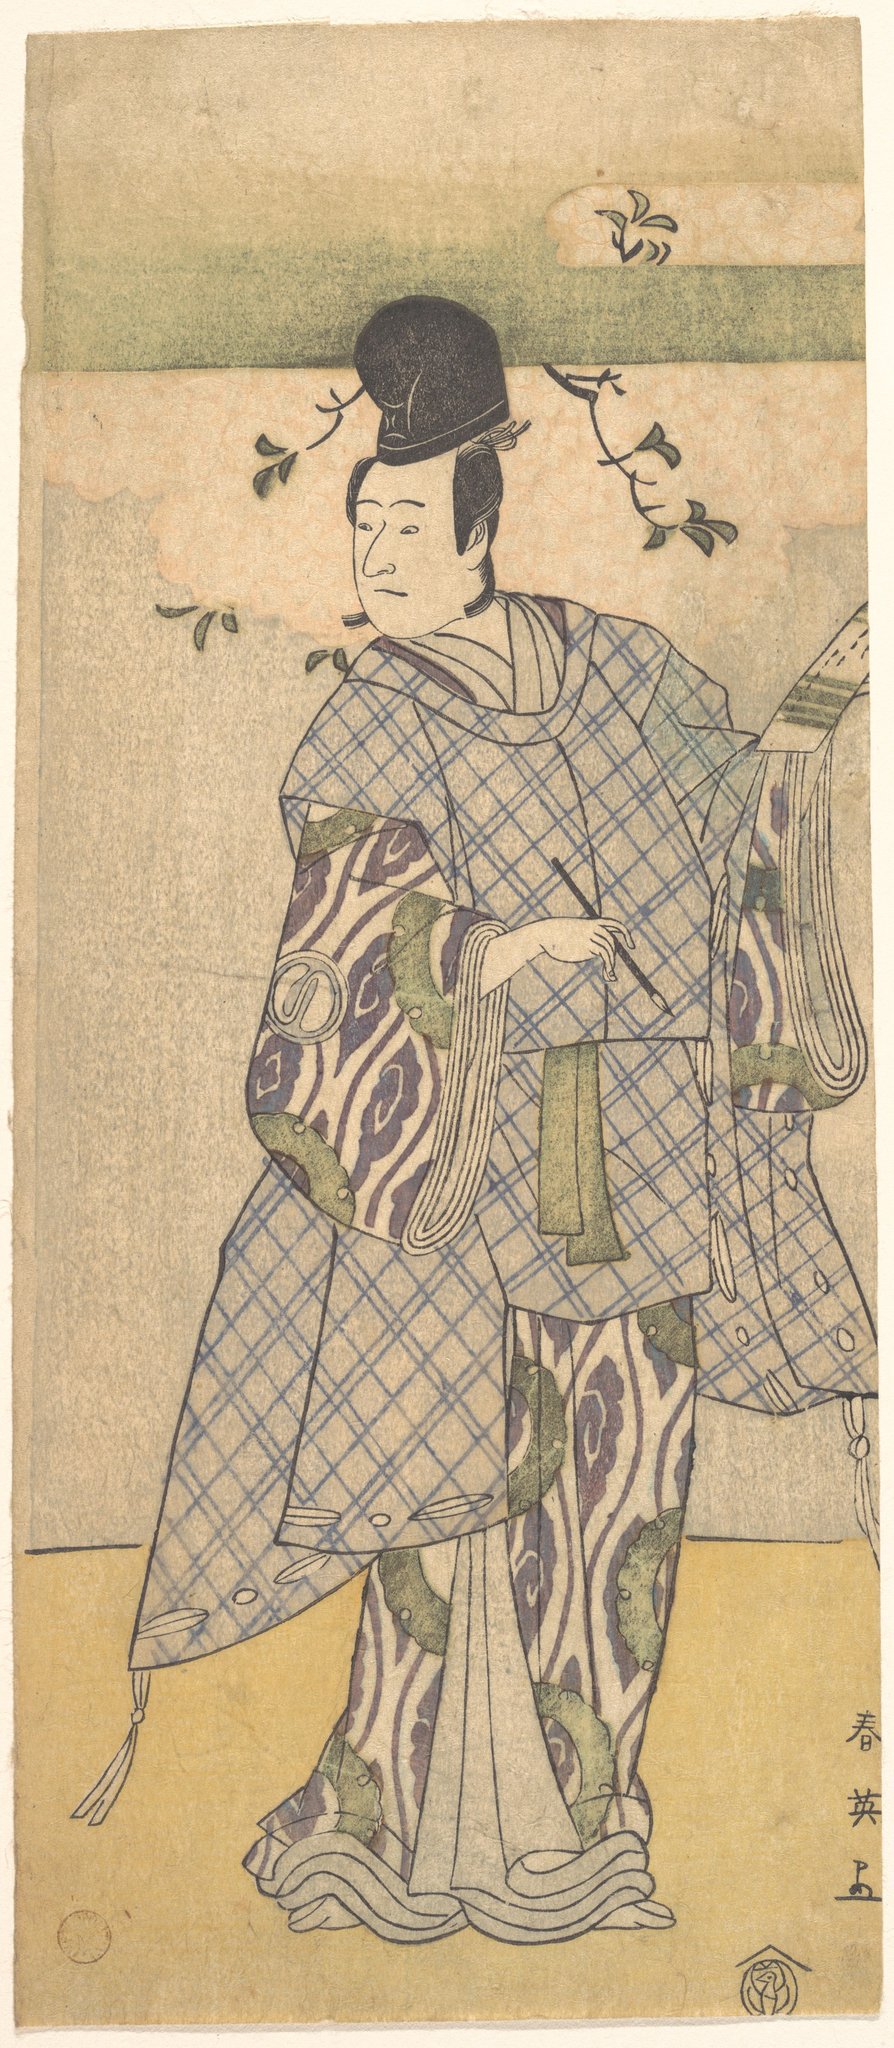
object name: print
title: The Actor Sawamura Sojuro III as a Nobleman Writing Poetry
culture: japanese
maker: katsukawa shun'ei 勝川春英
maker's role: artist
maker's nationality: japanese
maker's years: 1762-1819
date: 1782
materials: ink, paper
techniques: woodblock print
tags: men,actors